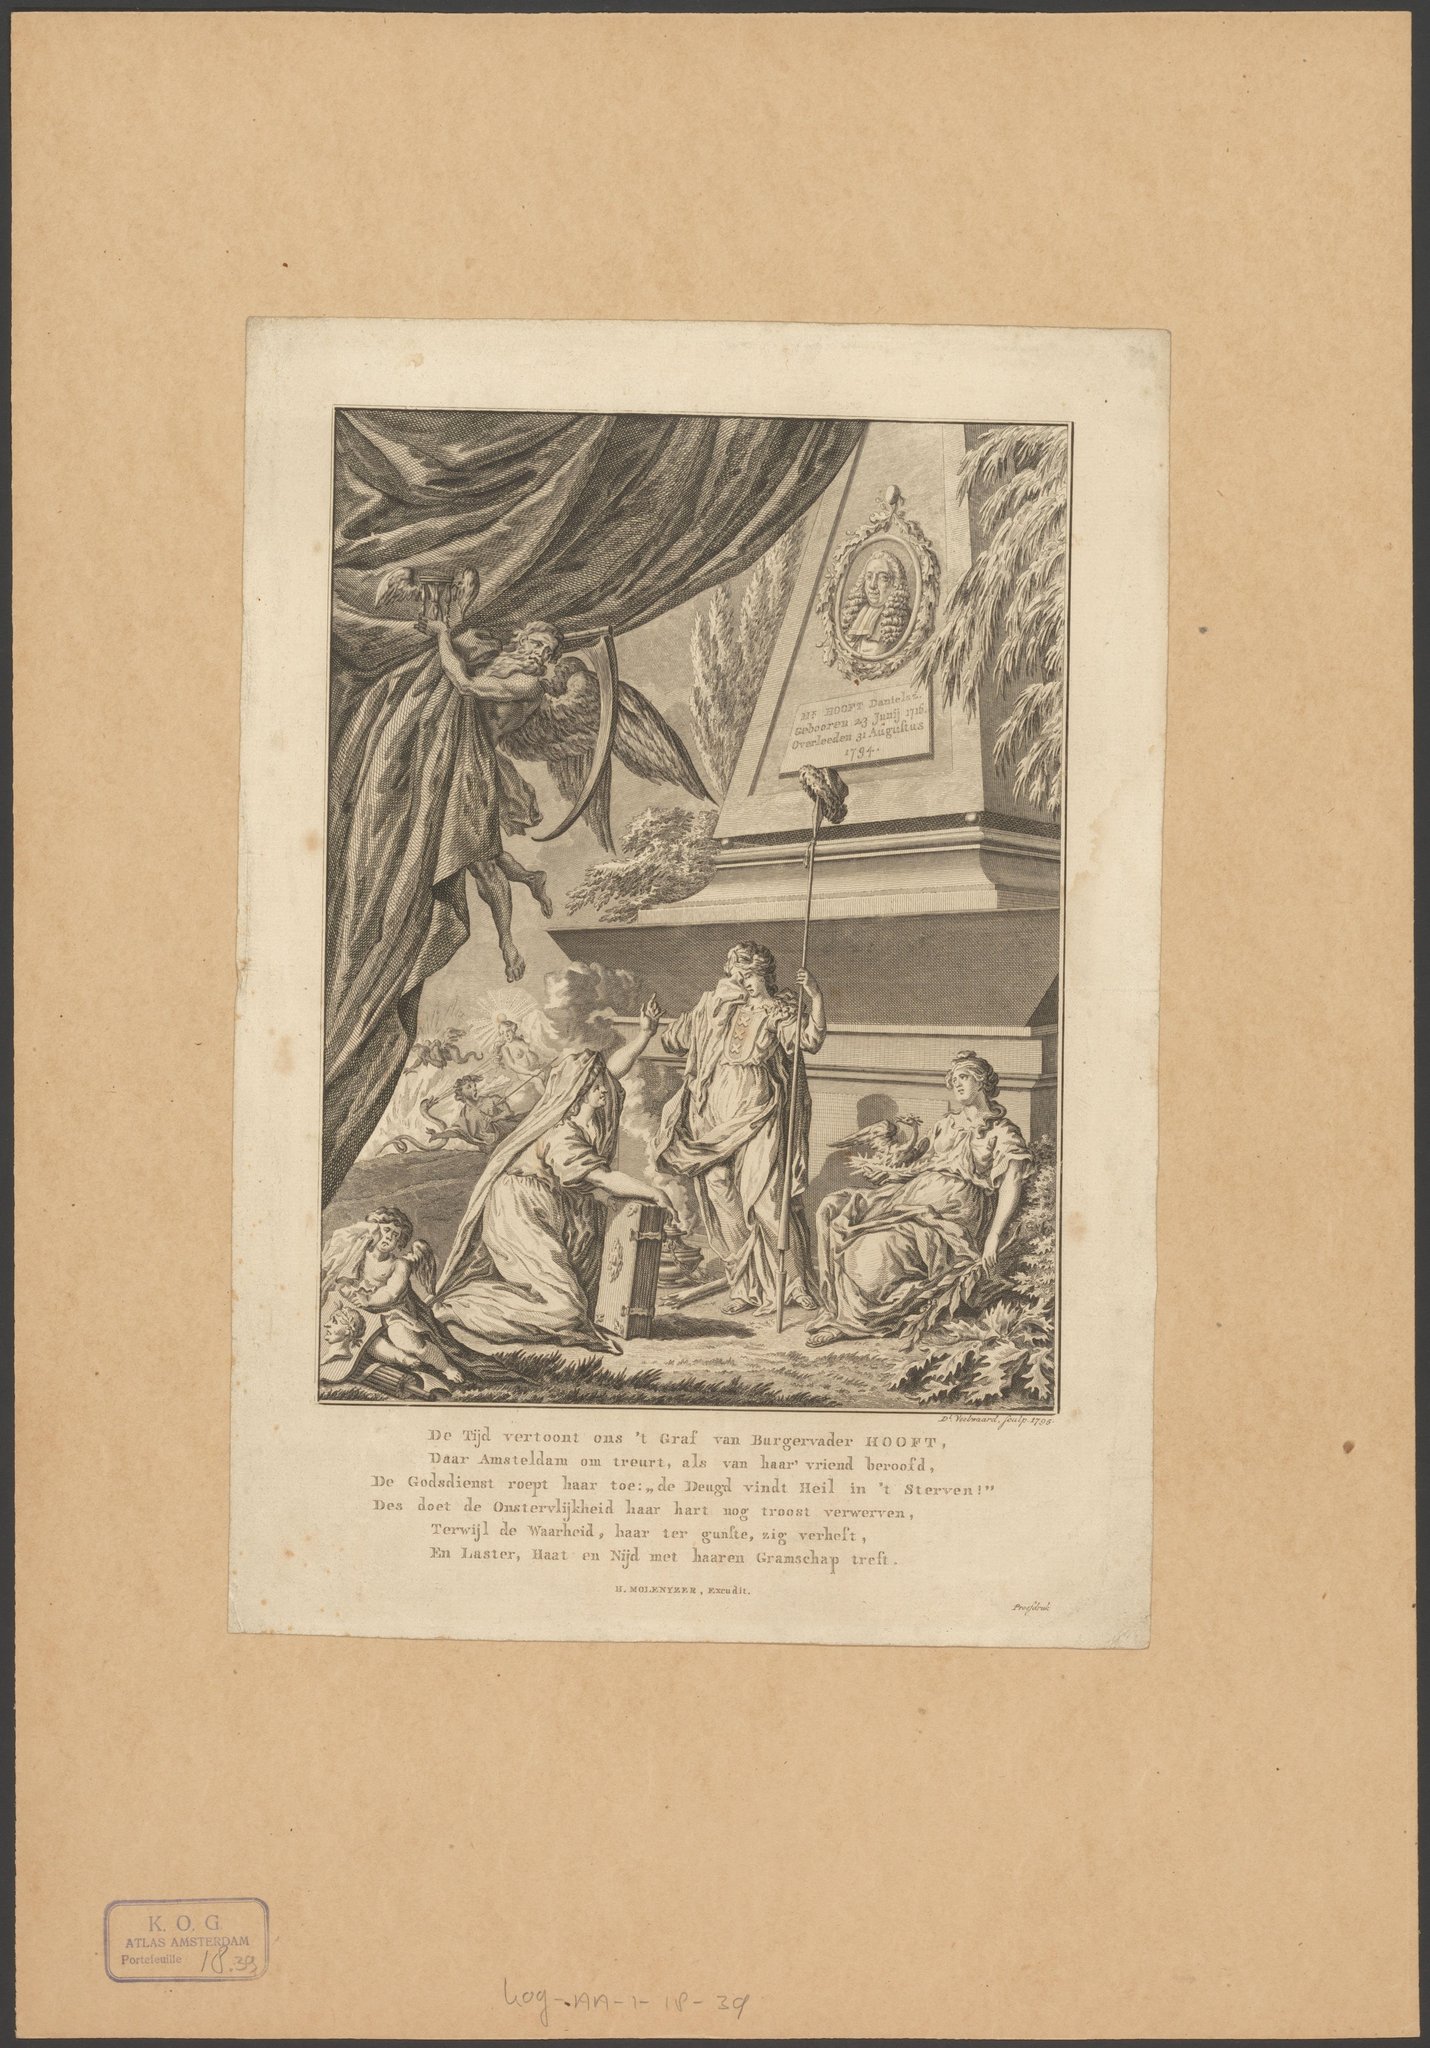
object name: print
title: Grafmonument voor Hendrik Daniëlsz. Hooft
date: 1795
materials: paper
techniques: engraving, etching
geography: amsterdam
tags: amsterdam, mayor, hendrik danielsz. hooft, grave-building, monumental tomb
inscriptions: collector's mark: ‘18.39’ Lugt 1641b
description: Onderwerpsrubriek binnen de Atlas Amsterdam: Herinneringen aan regeringsleden en hunne huisgezinnen [voor 1800].